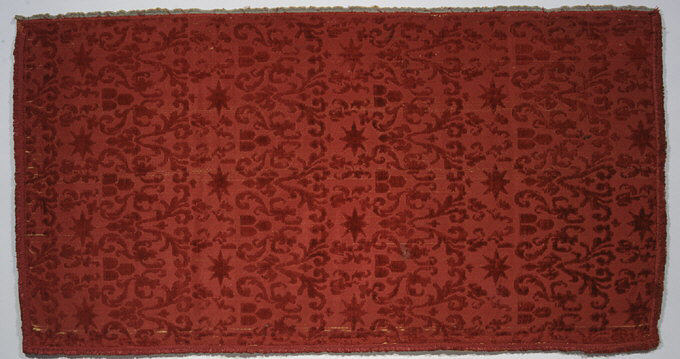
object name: piece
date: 1601-1633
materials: silk